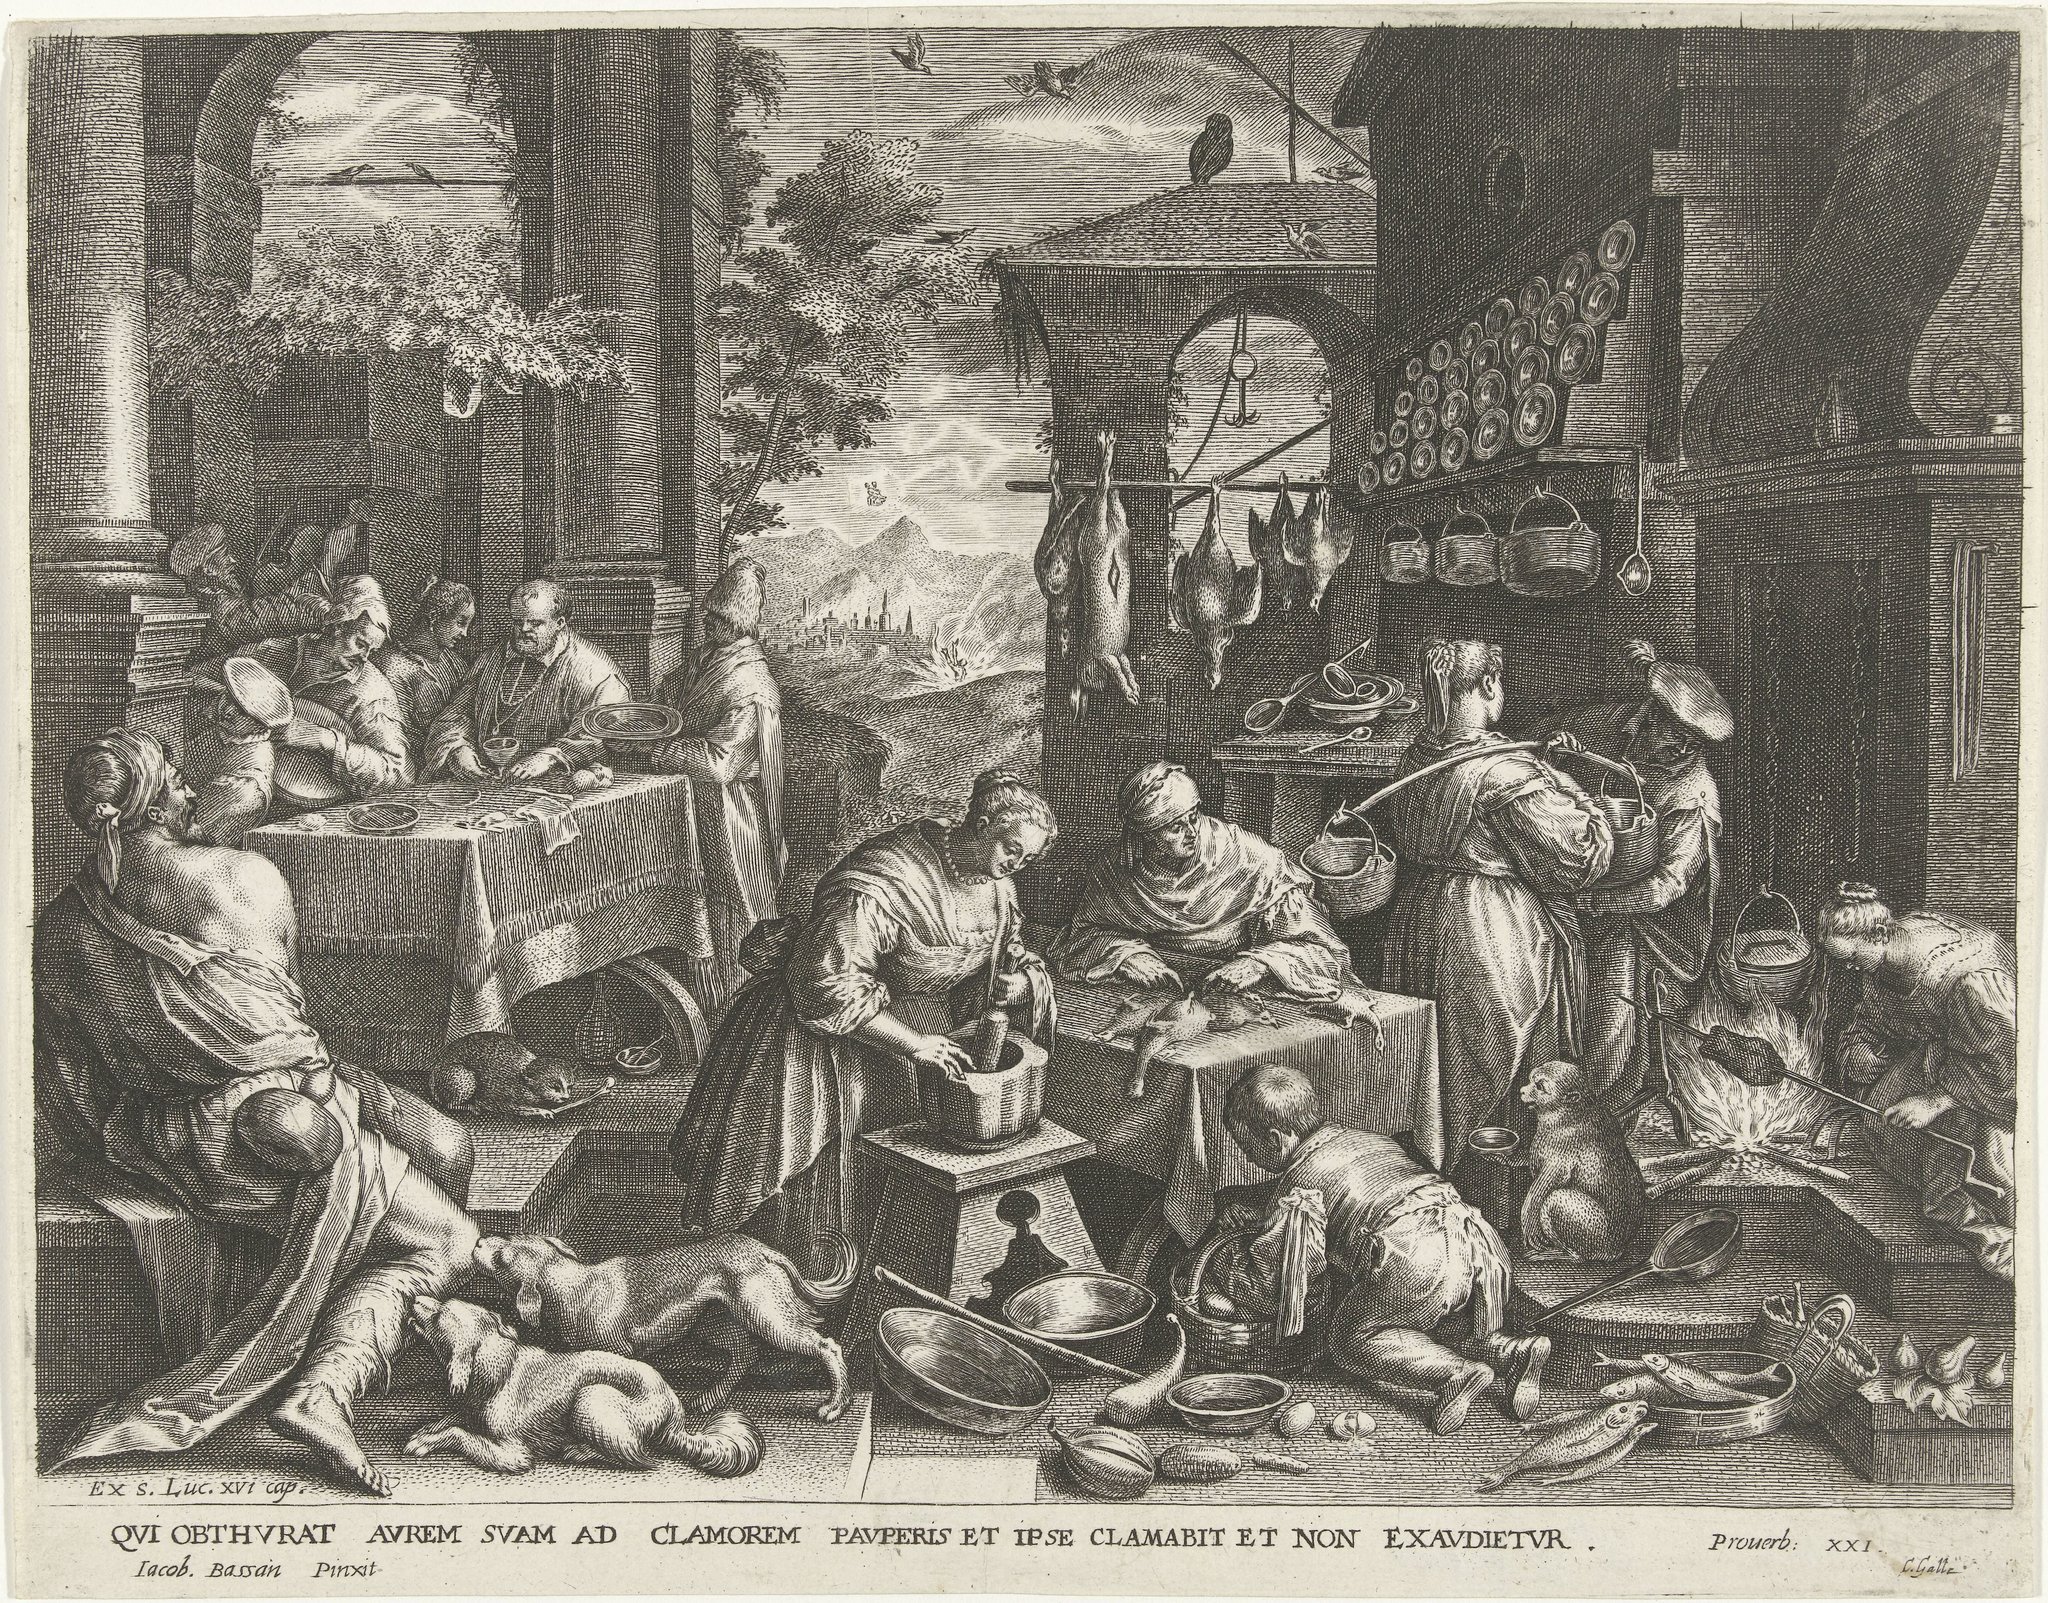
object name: print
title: Gelijkenis van de rijke man en de arme Lazarus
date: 1586-1650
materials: paper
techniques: engraving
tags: the rich man (dives) is feasting, while poor lazarus is starving at the gate (dogs licking lazarus' sores) (luke 16:19-31)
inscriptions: collector's mark: Lugt 240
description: De rijke man laat zich in zijn huis rijkelijk bedienen. In de keuken wordt een uitgebreid feestmaal bereid. Voor de deur van het huis ligt de arme Lazarus, een bedelaar, te verhongeren. Twee honden likken zijn wonden. Op de achtergrond is in een landschap te zien hoe de rijke man in het vuur van de hel terechtkomt, en Lazarus ten hemel opgenomen wordt.